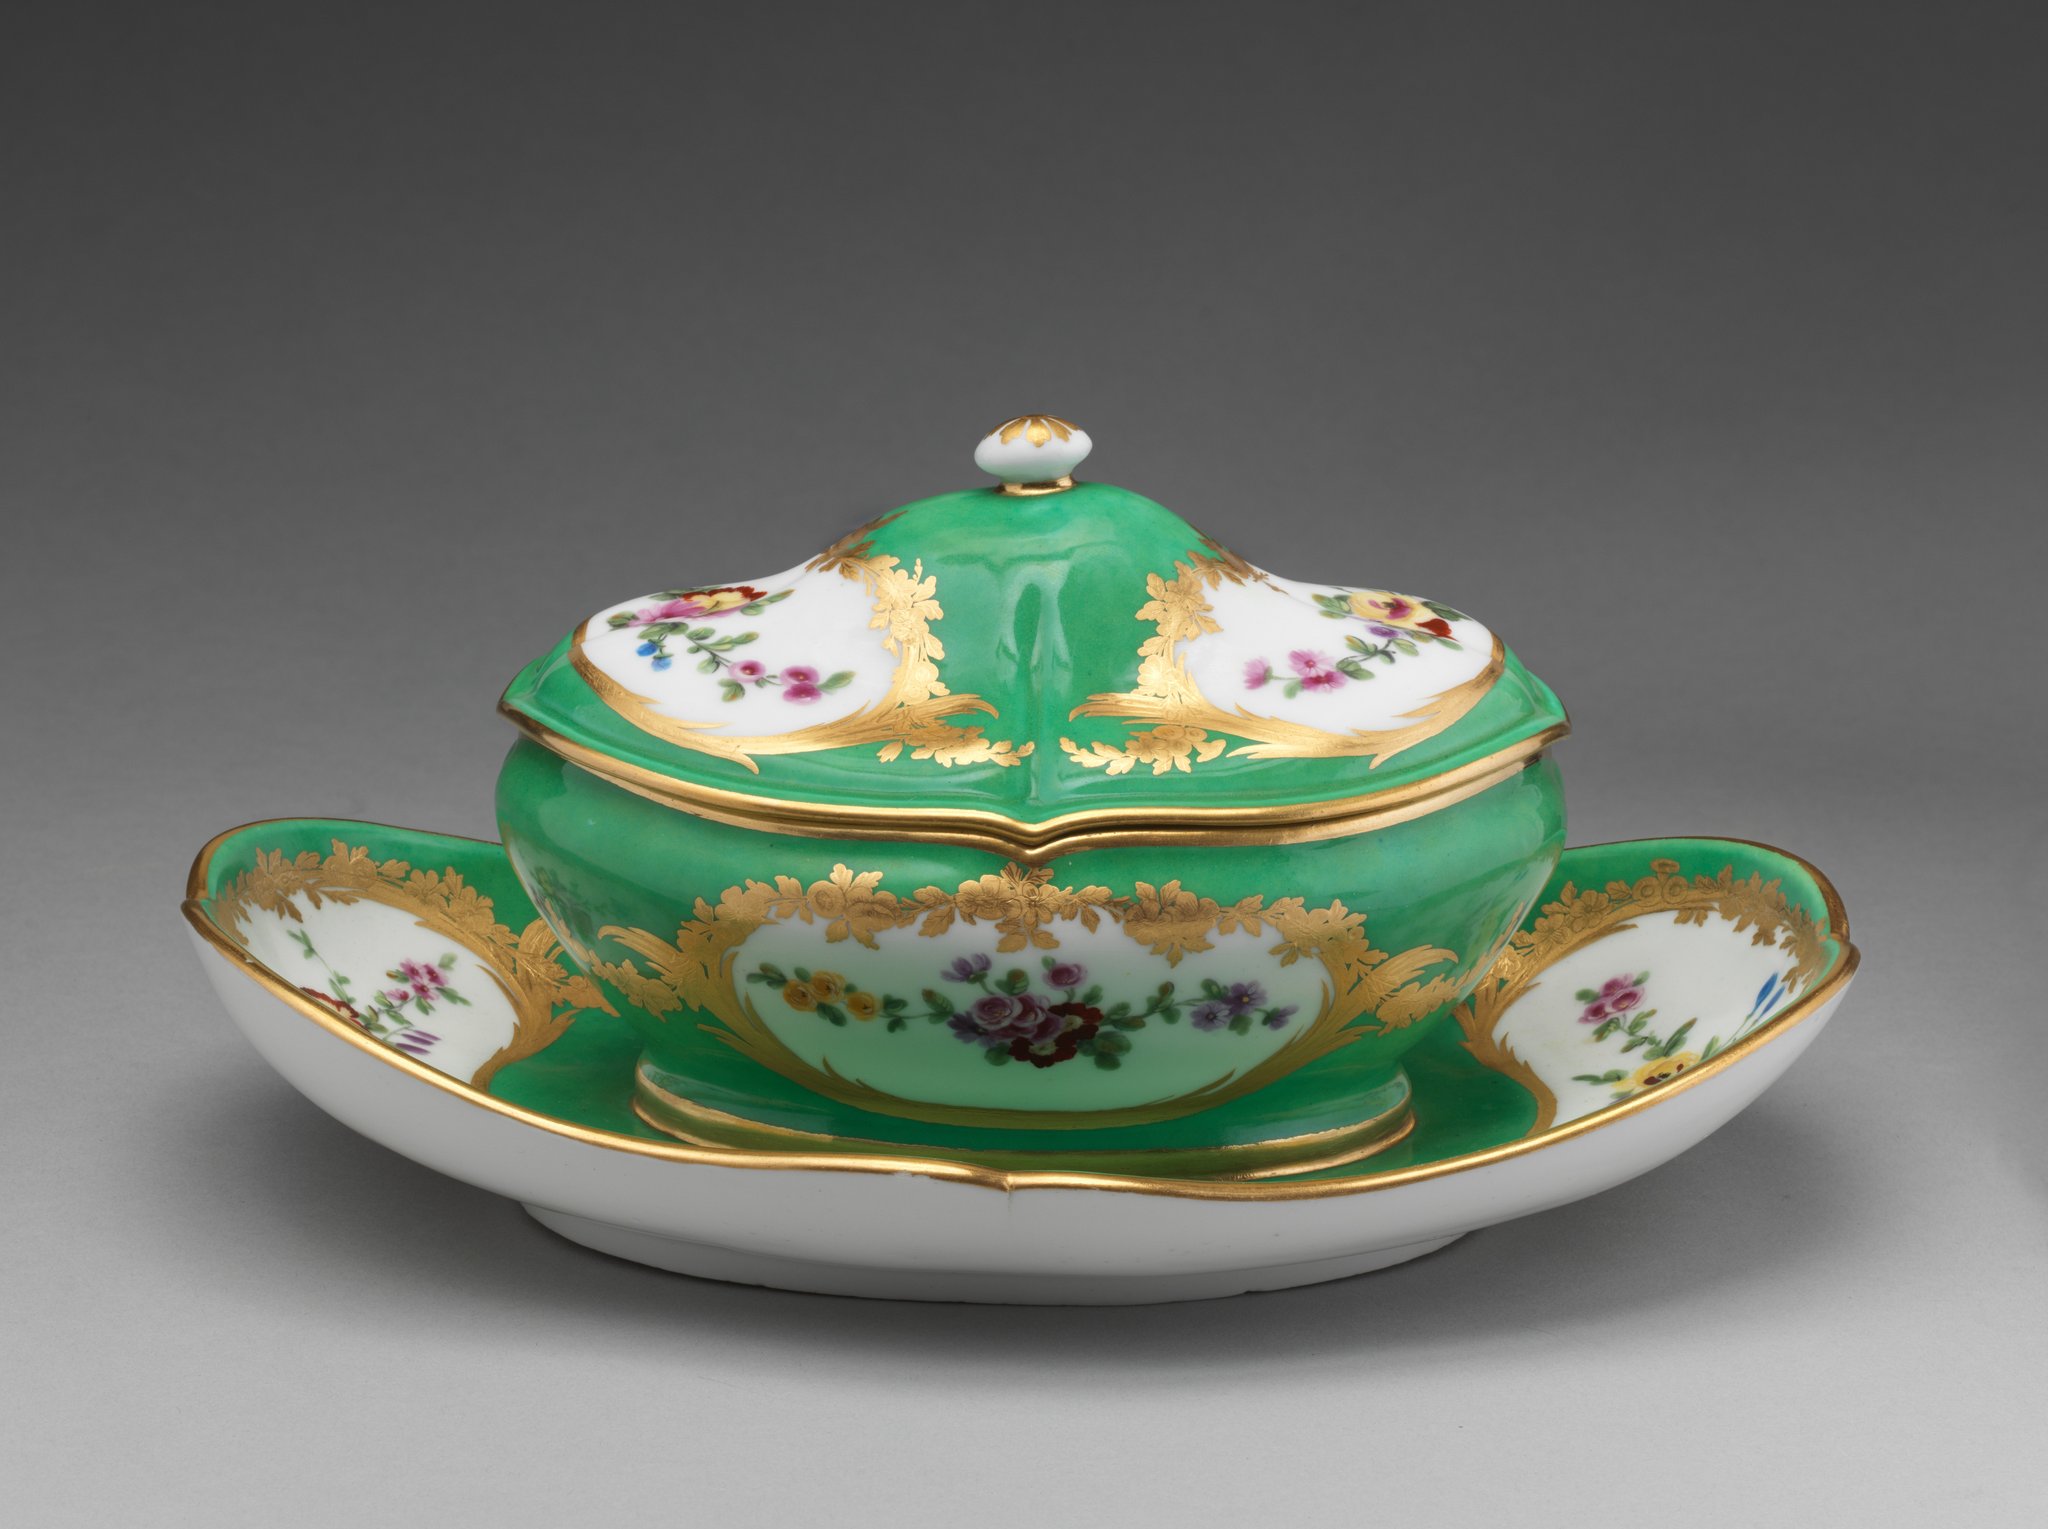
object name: sugar bowl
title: Sugar bowl (one of four) (part of a service)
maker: sèvres manufactory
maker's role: manufactory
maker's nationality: french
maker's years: 1740-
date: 1775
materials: soft paste porcelain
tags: roses